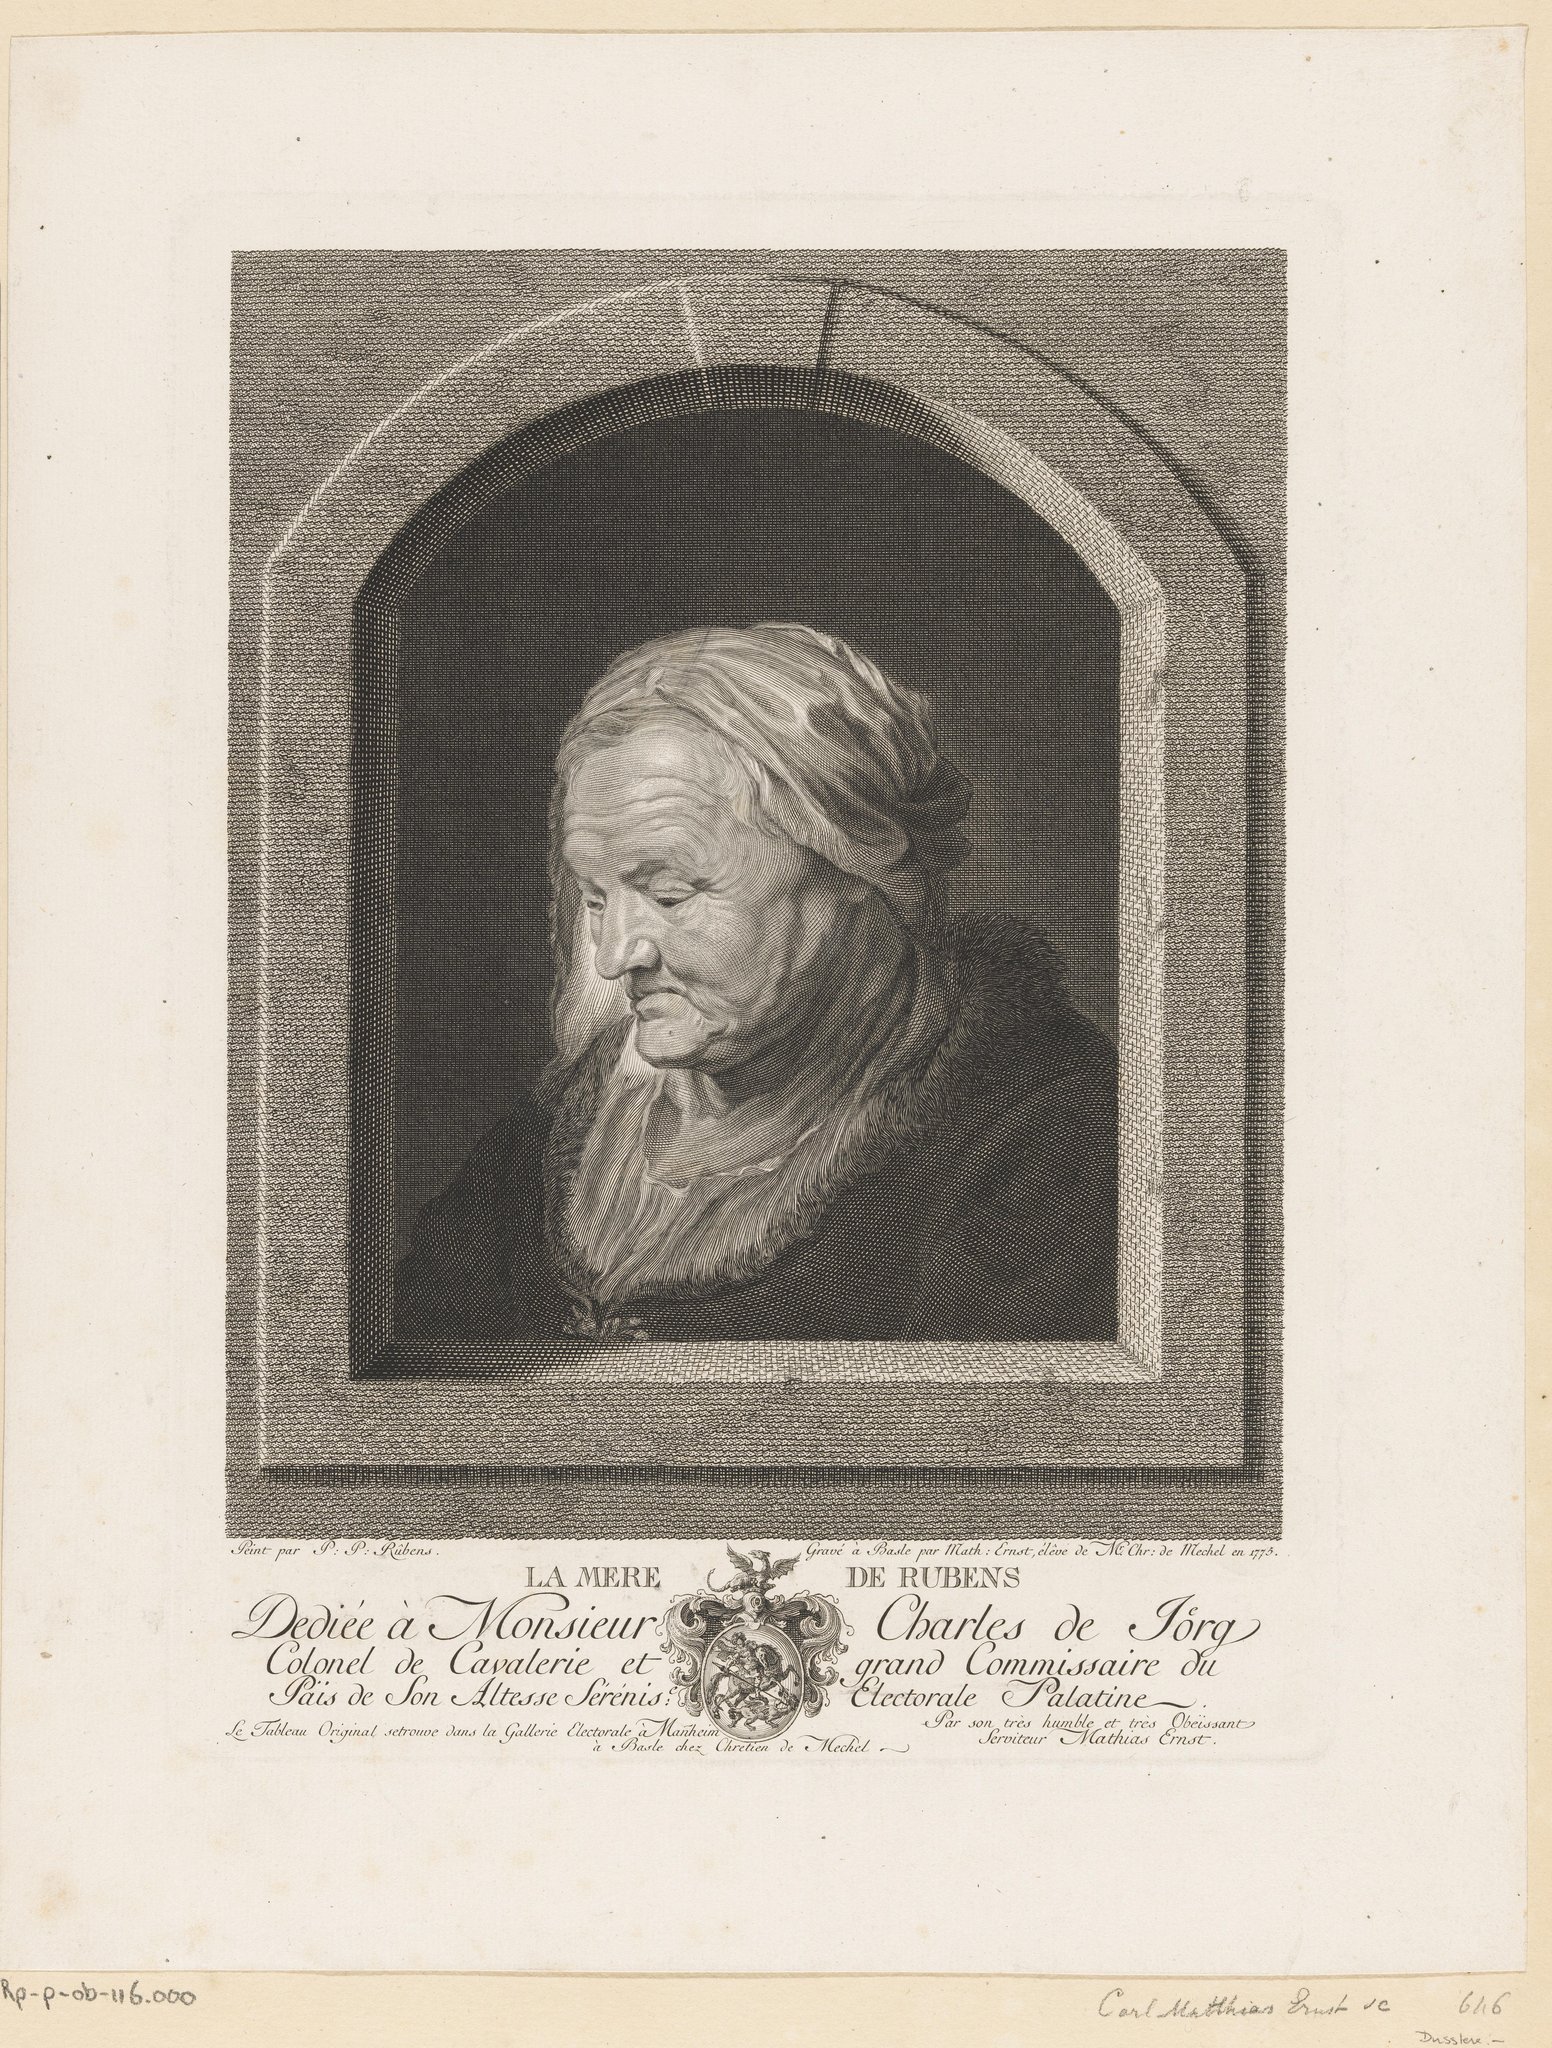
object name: print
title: Portret van Maria Pypelinckx, de moeder van Peter Paul Rubens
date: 1775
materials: paper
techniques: engraving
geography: basel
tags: antwerp, historical persons - bb - woman, armorial bearing, heraldry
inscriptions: collector's mark: Lugt 240